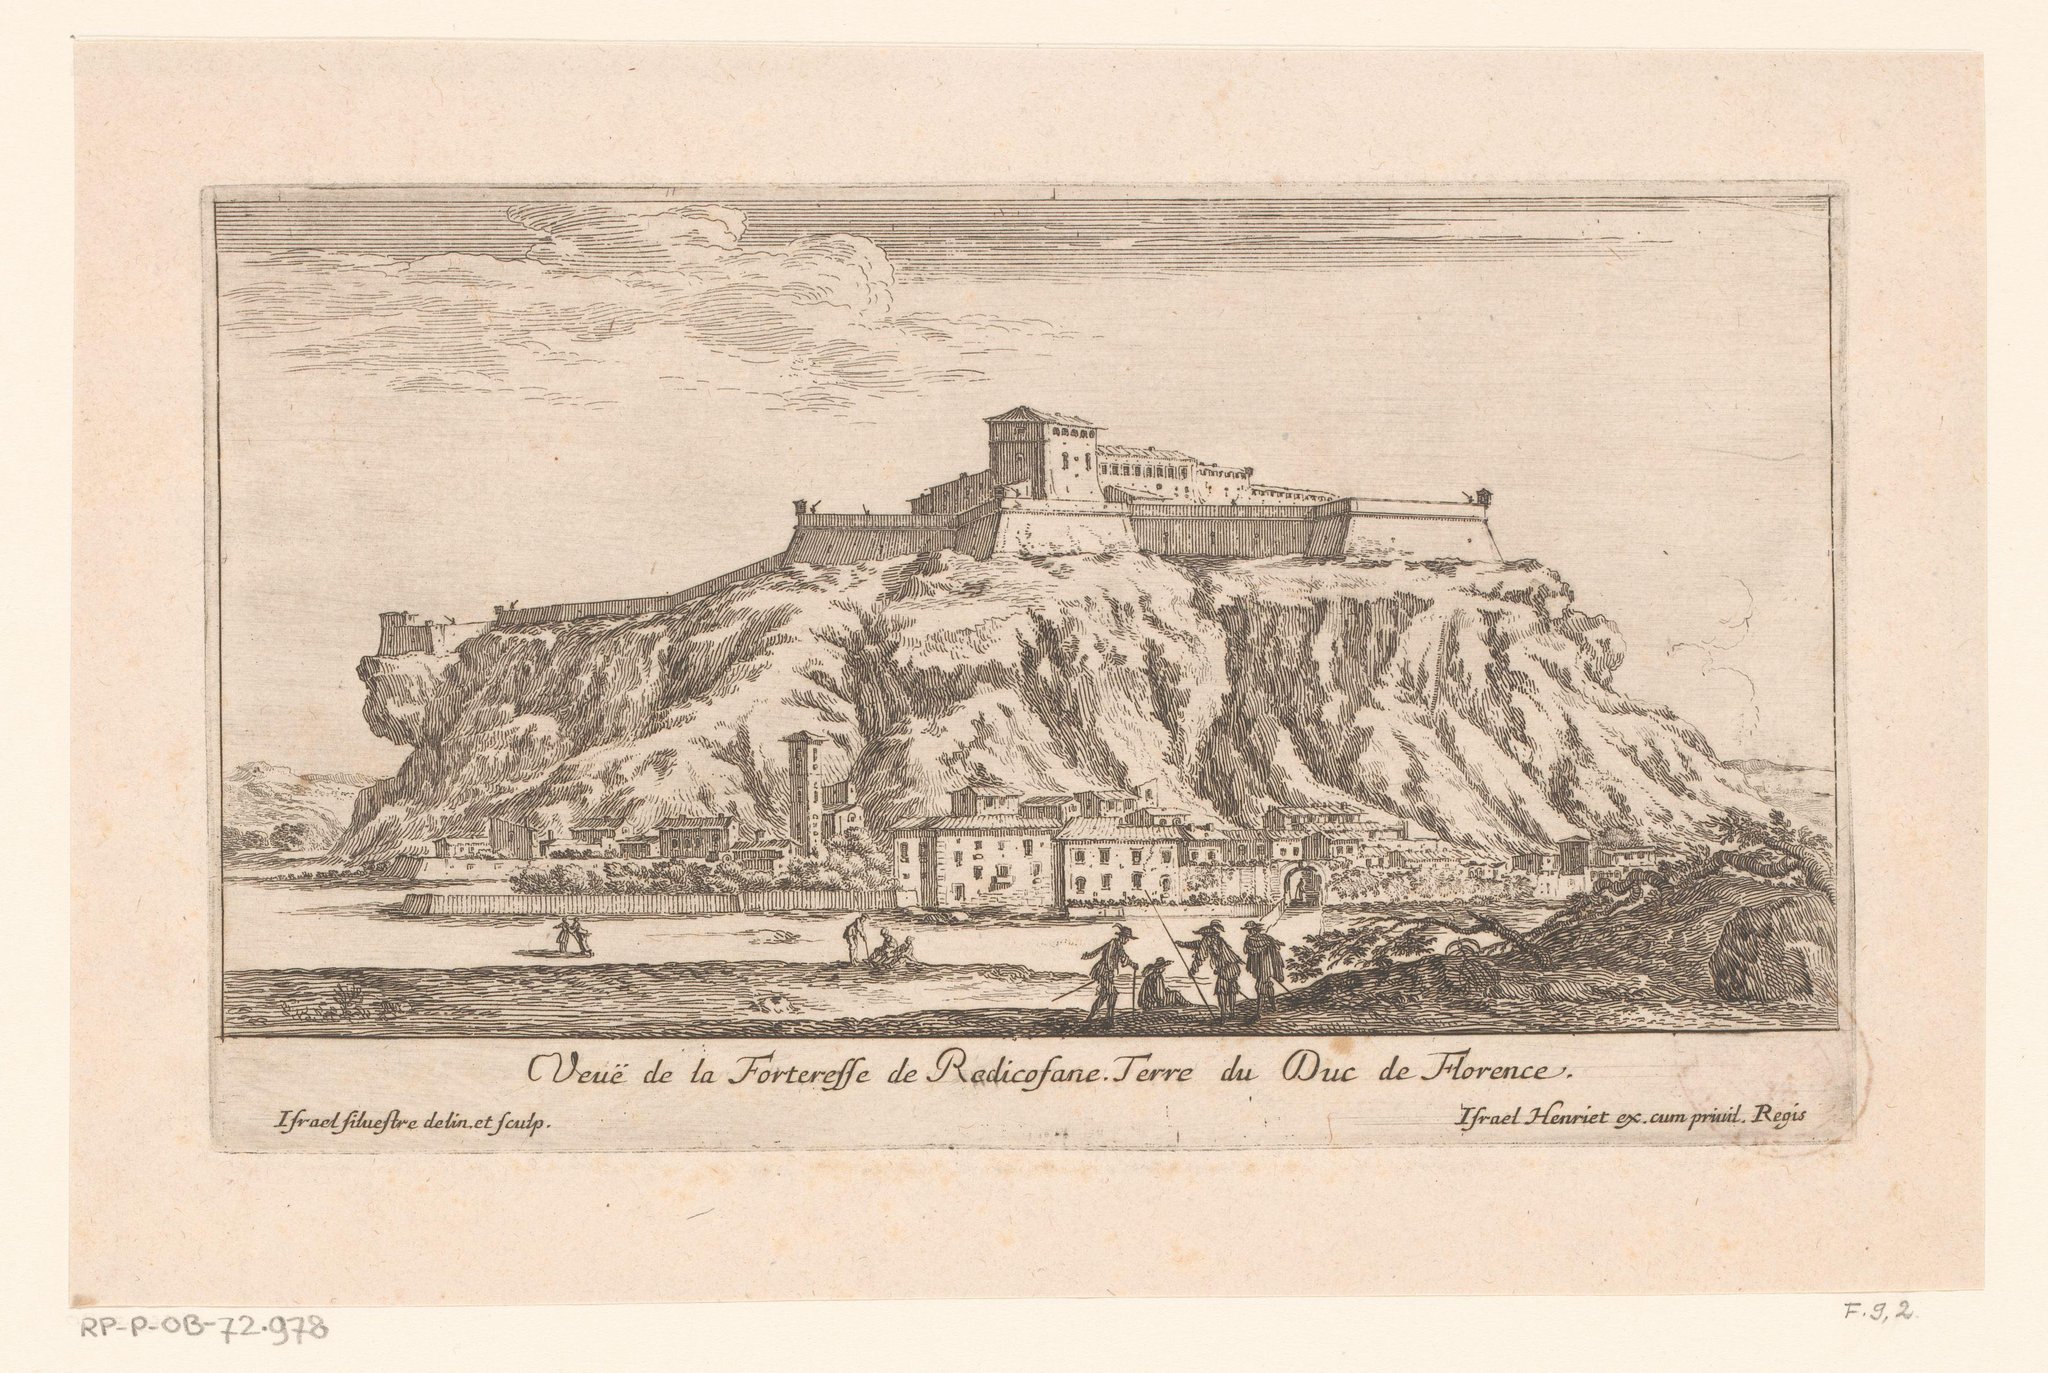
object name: print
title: Vues d'Italie et de France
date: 1654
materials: paper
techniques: etching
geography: france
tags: fortifications, military engineering, mountains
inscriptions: collector's mark: Lugt 240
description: Prent maakt deel uit van een serie van zestien prenten, deels ongenummerd.